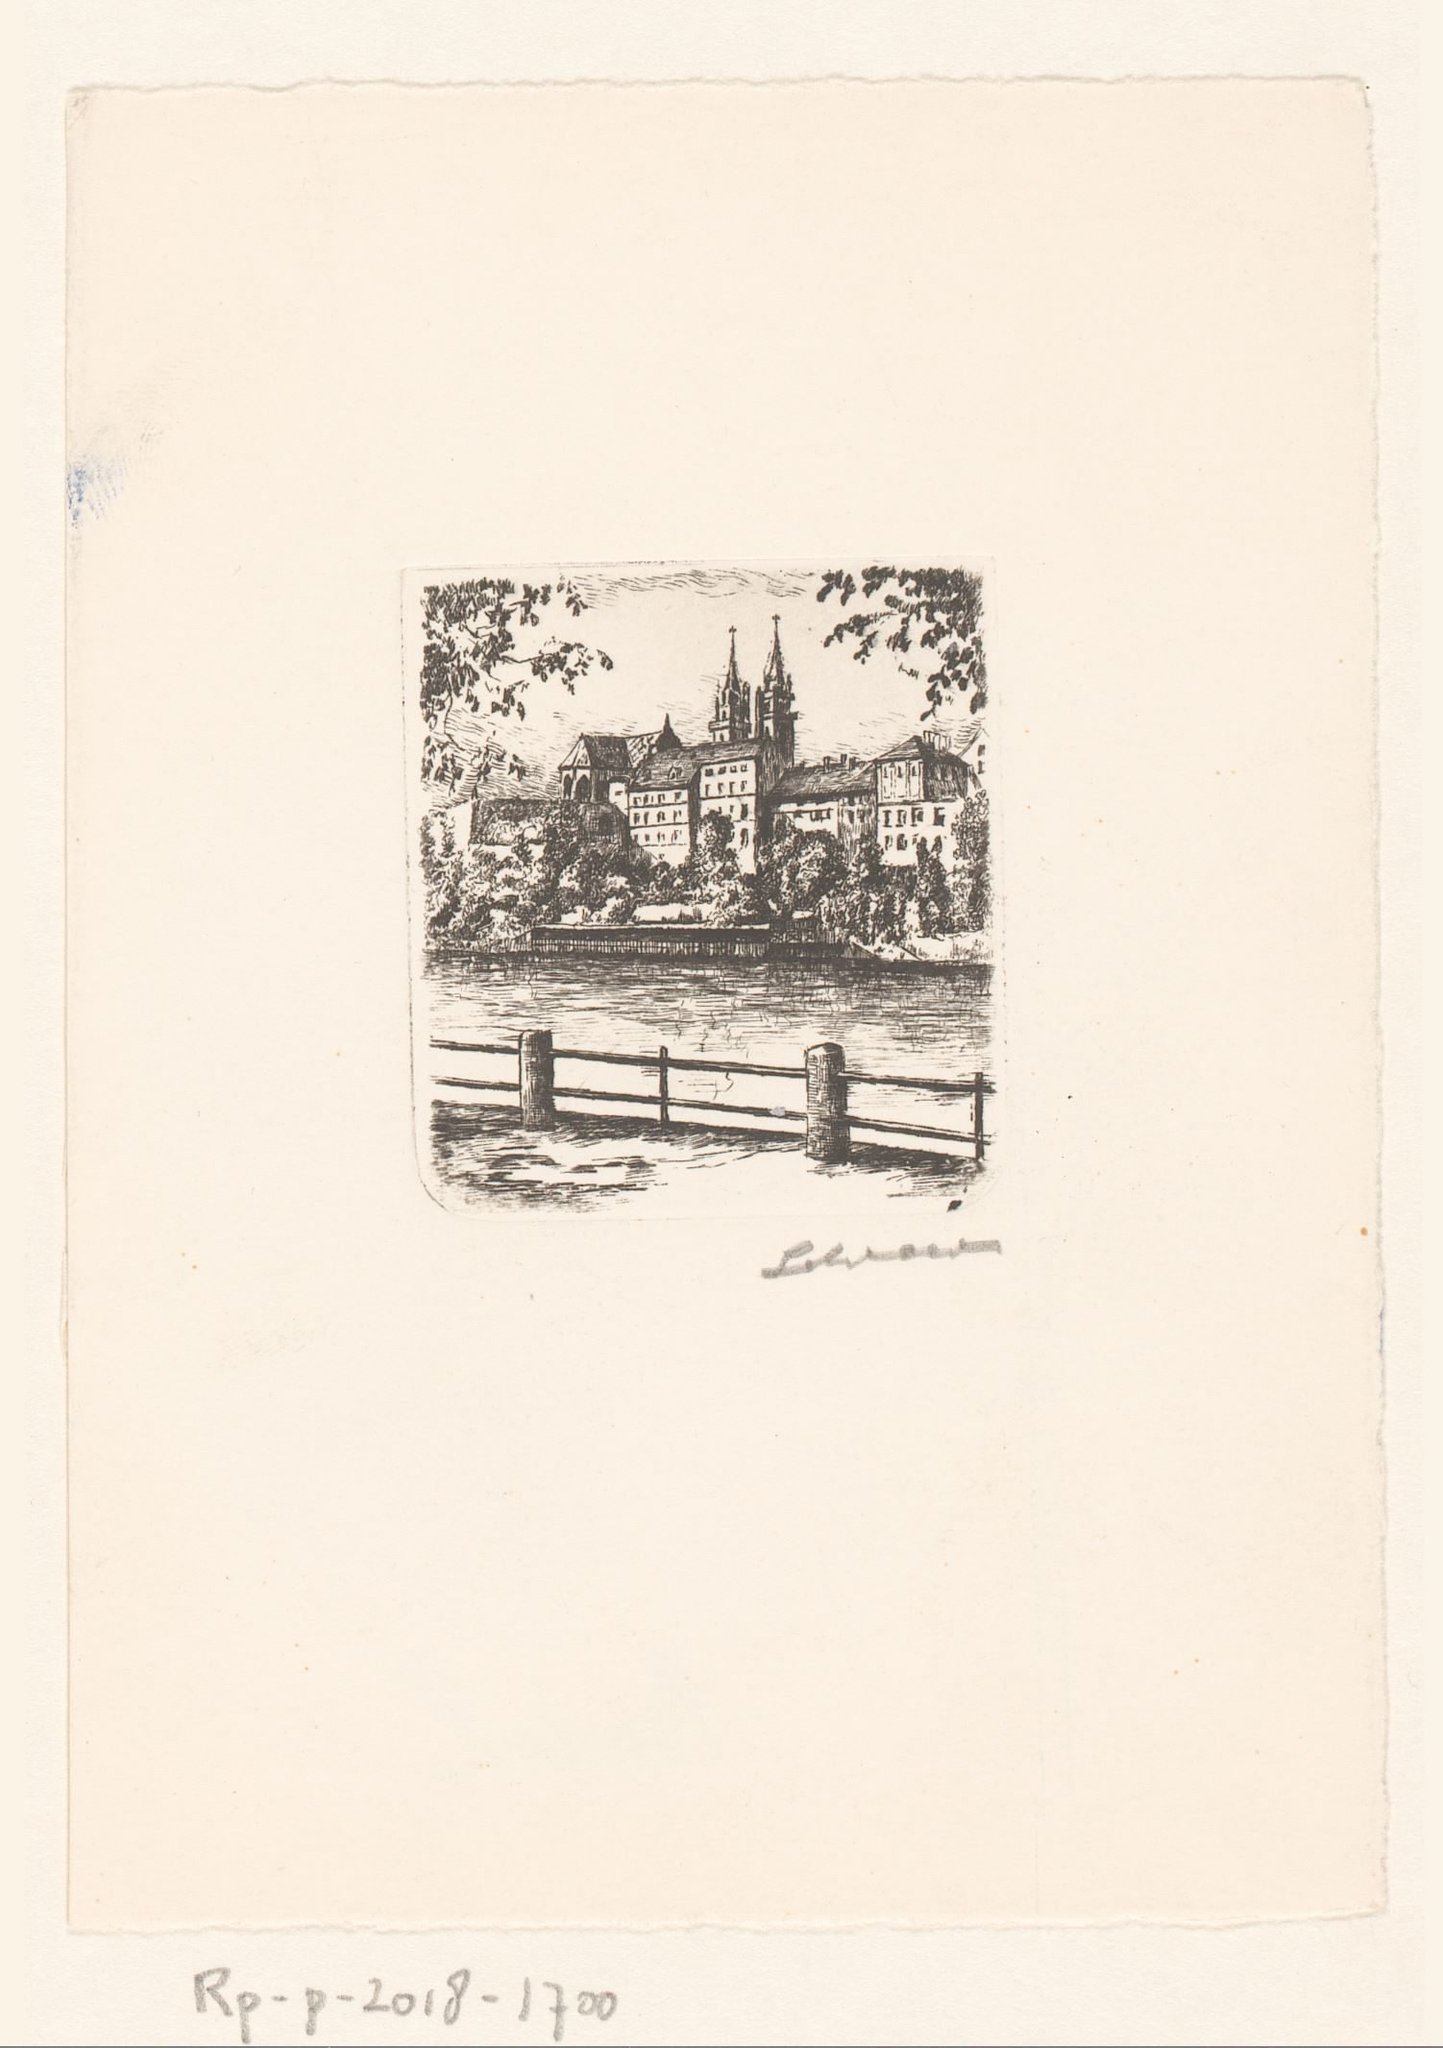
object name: print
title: Gezicht op het munster van Bazel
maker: Anonymous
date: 1850-1949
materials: paper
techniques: etching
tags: church (exterior), prospect of city, town panorama, silhouette of city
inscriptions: collector's mark: Lugt 2228